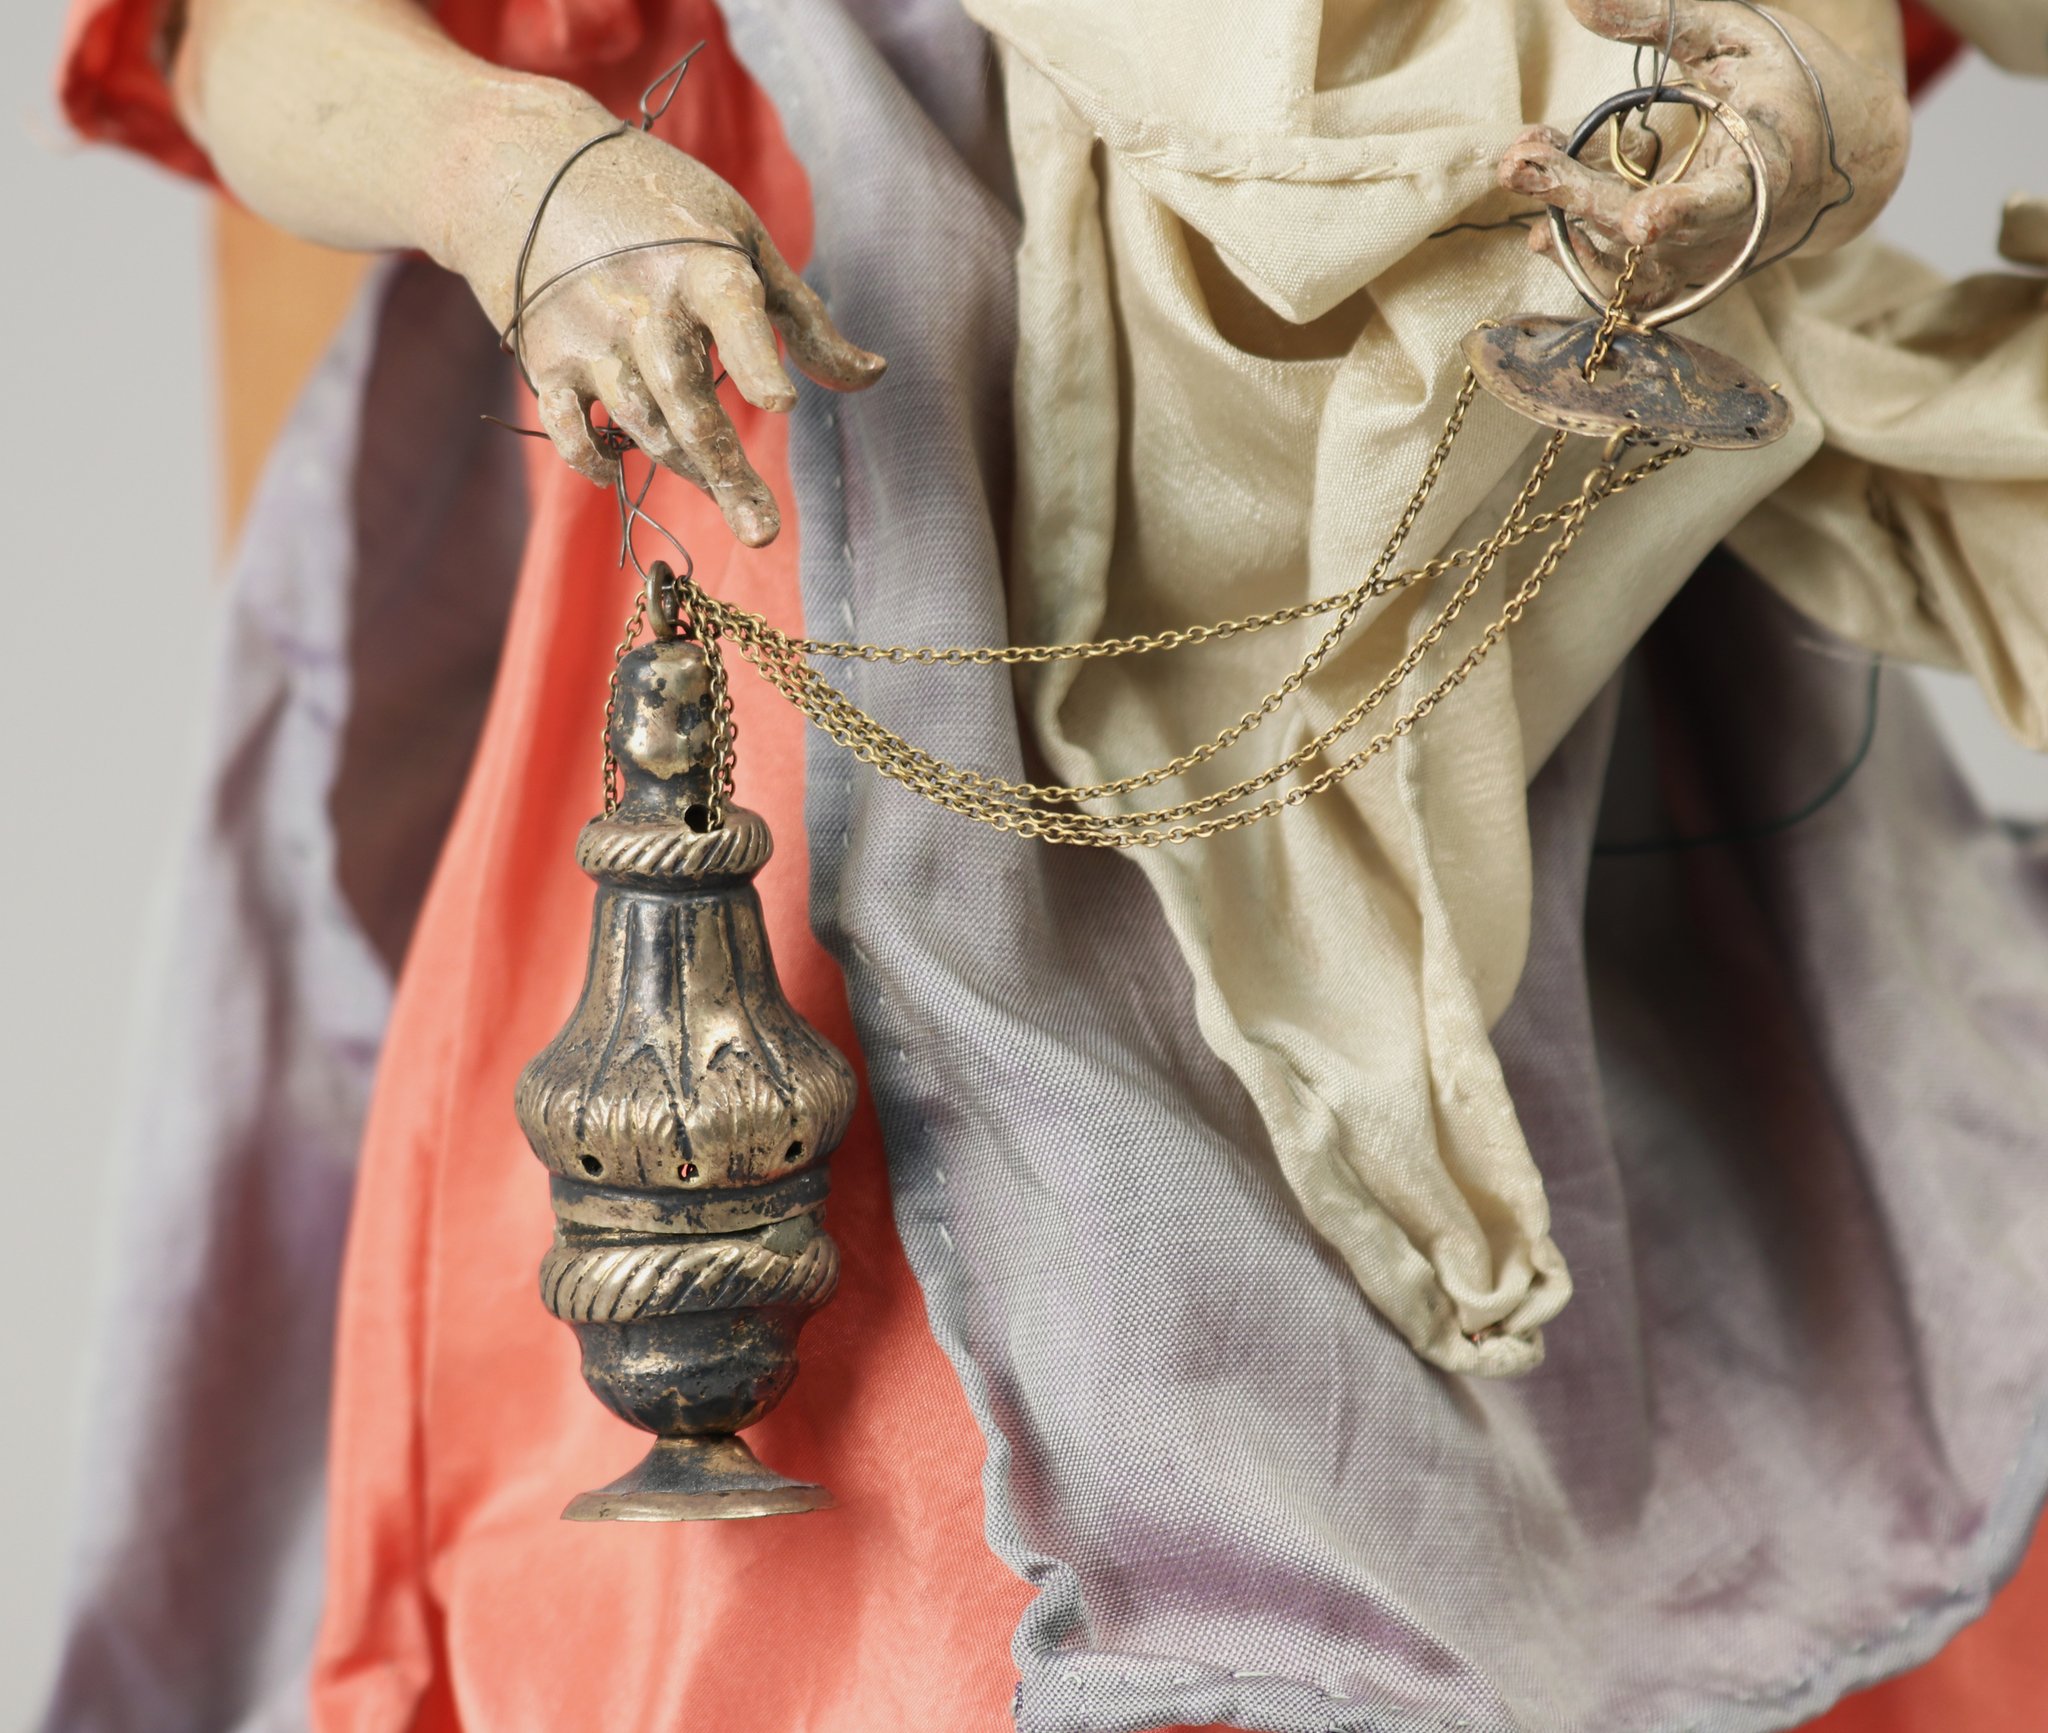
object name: crèche figure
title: Censer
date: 1751-1800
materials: silver gilt